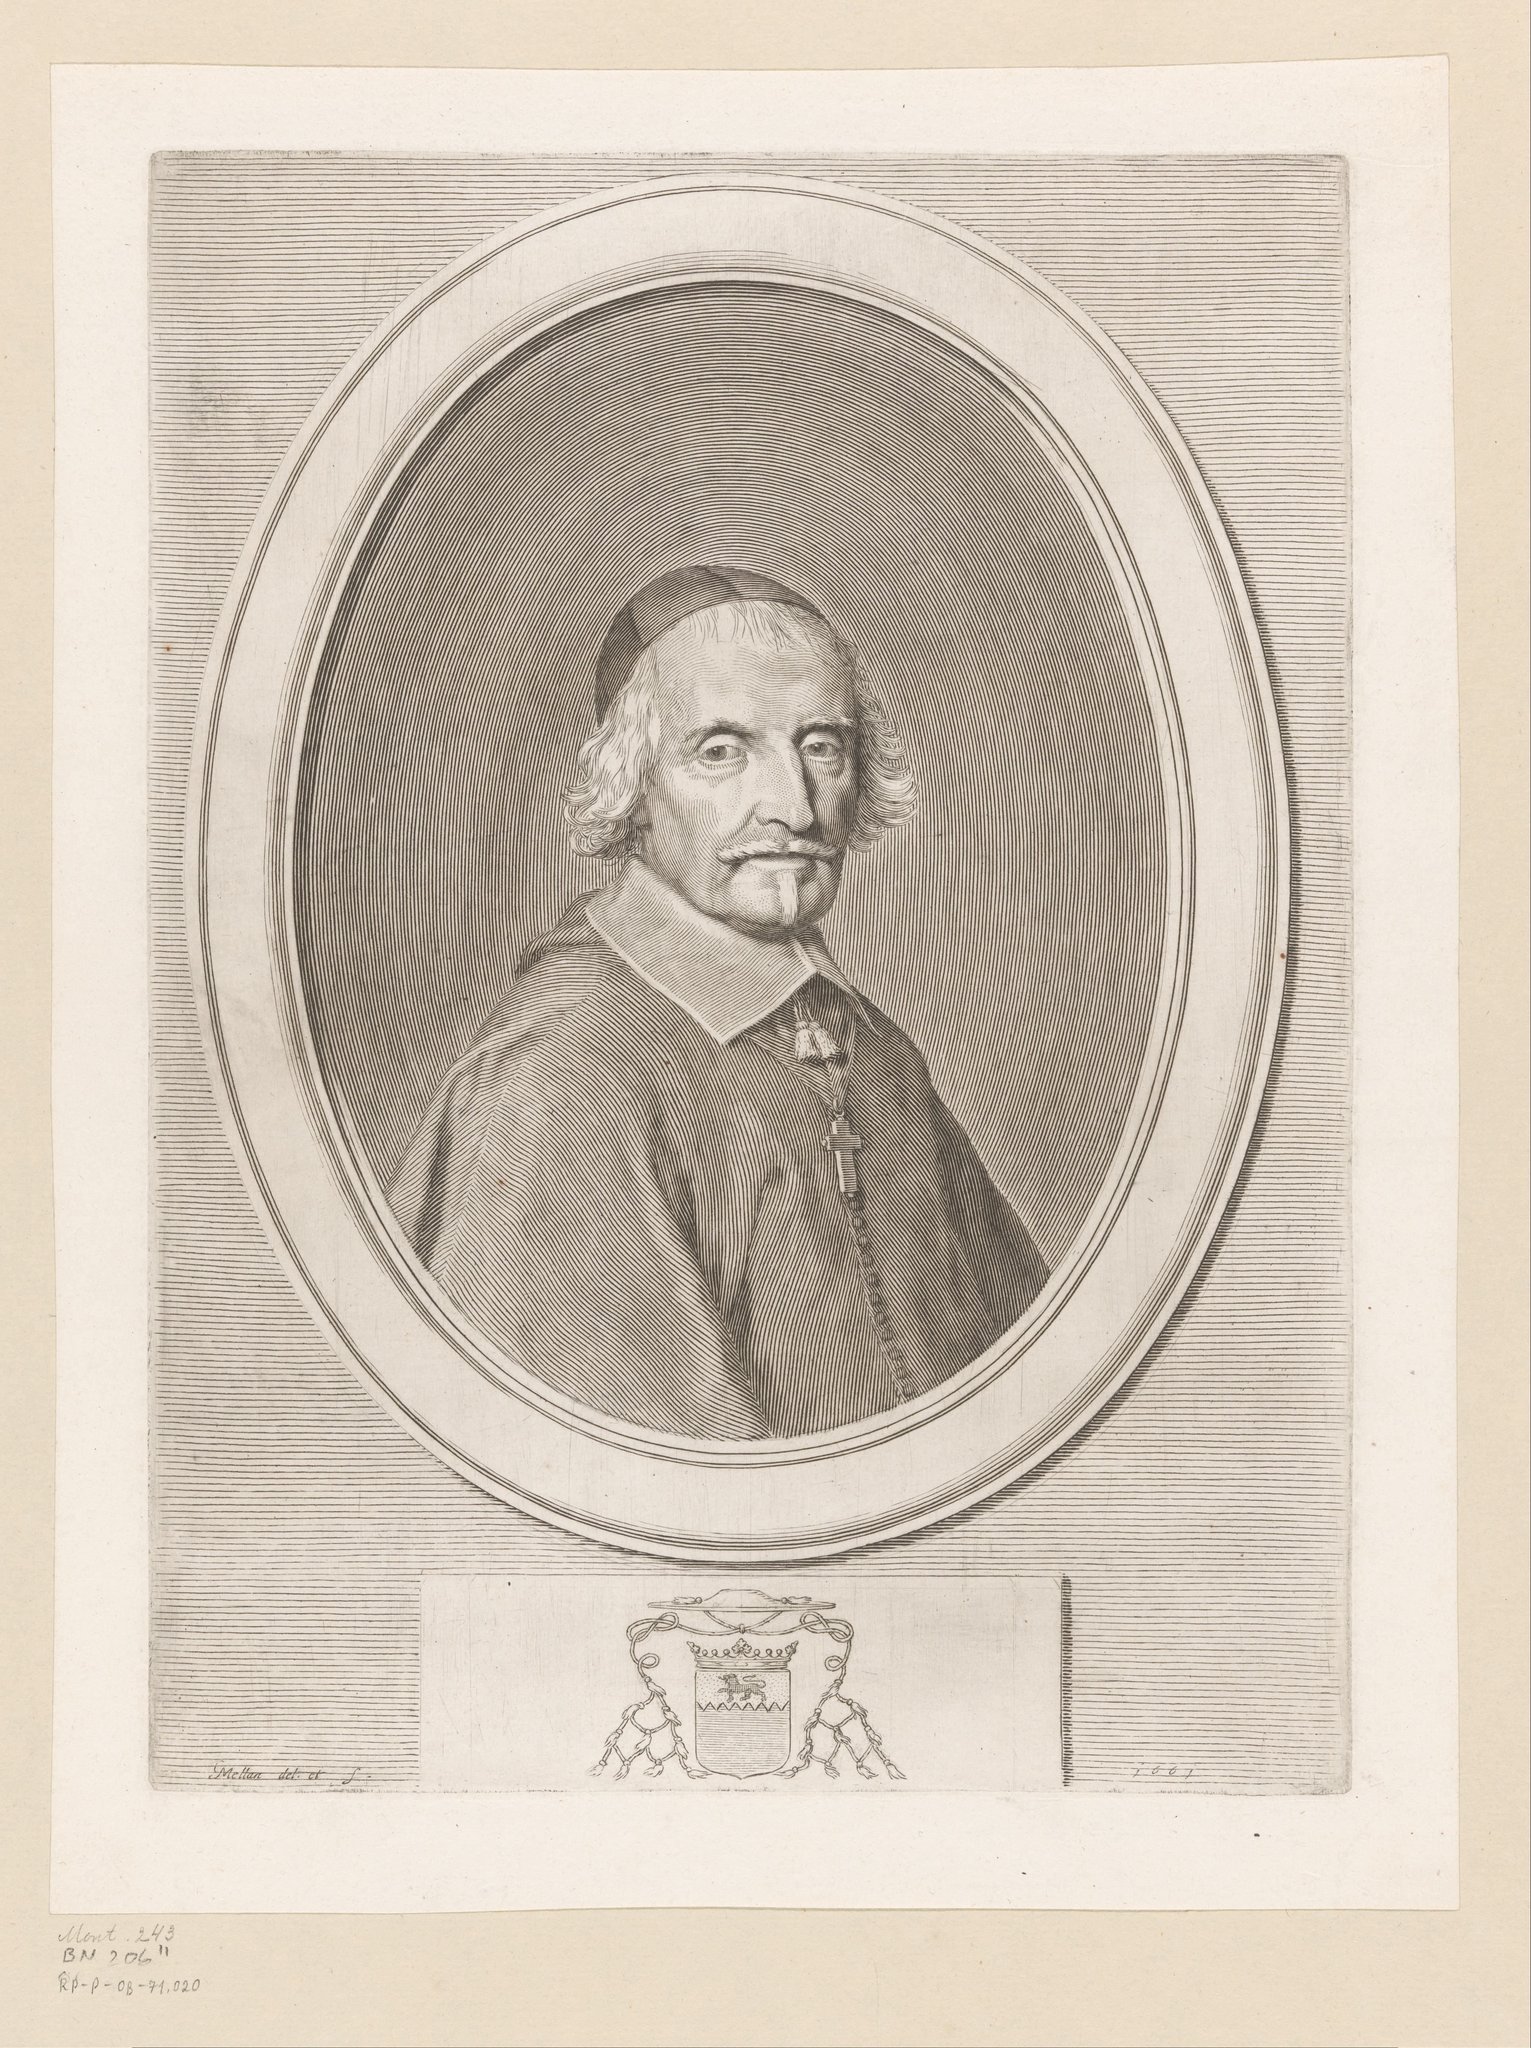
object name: print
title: Portret van François de Villemontée, bisschop van Saint-Malo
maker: claude mellan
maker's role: draughtsman, print maker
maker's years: 1598-1688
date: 1661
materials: paper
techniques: engraving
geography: france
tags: paris, historical persons, armorial bearing, heraldry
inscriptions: collector's mark: Lugt 240